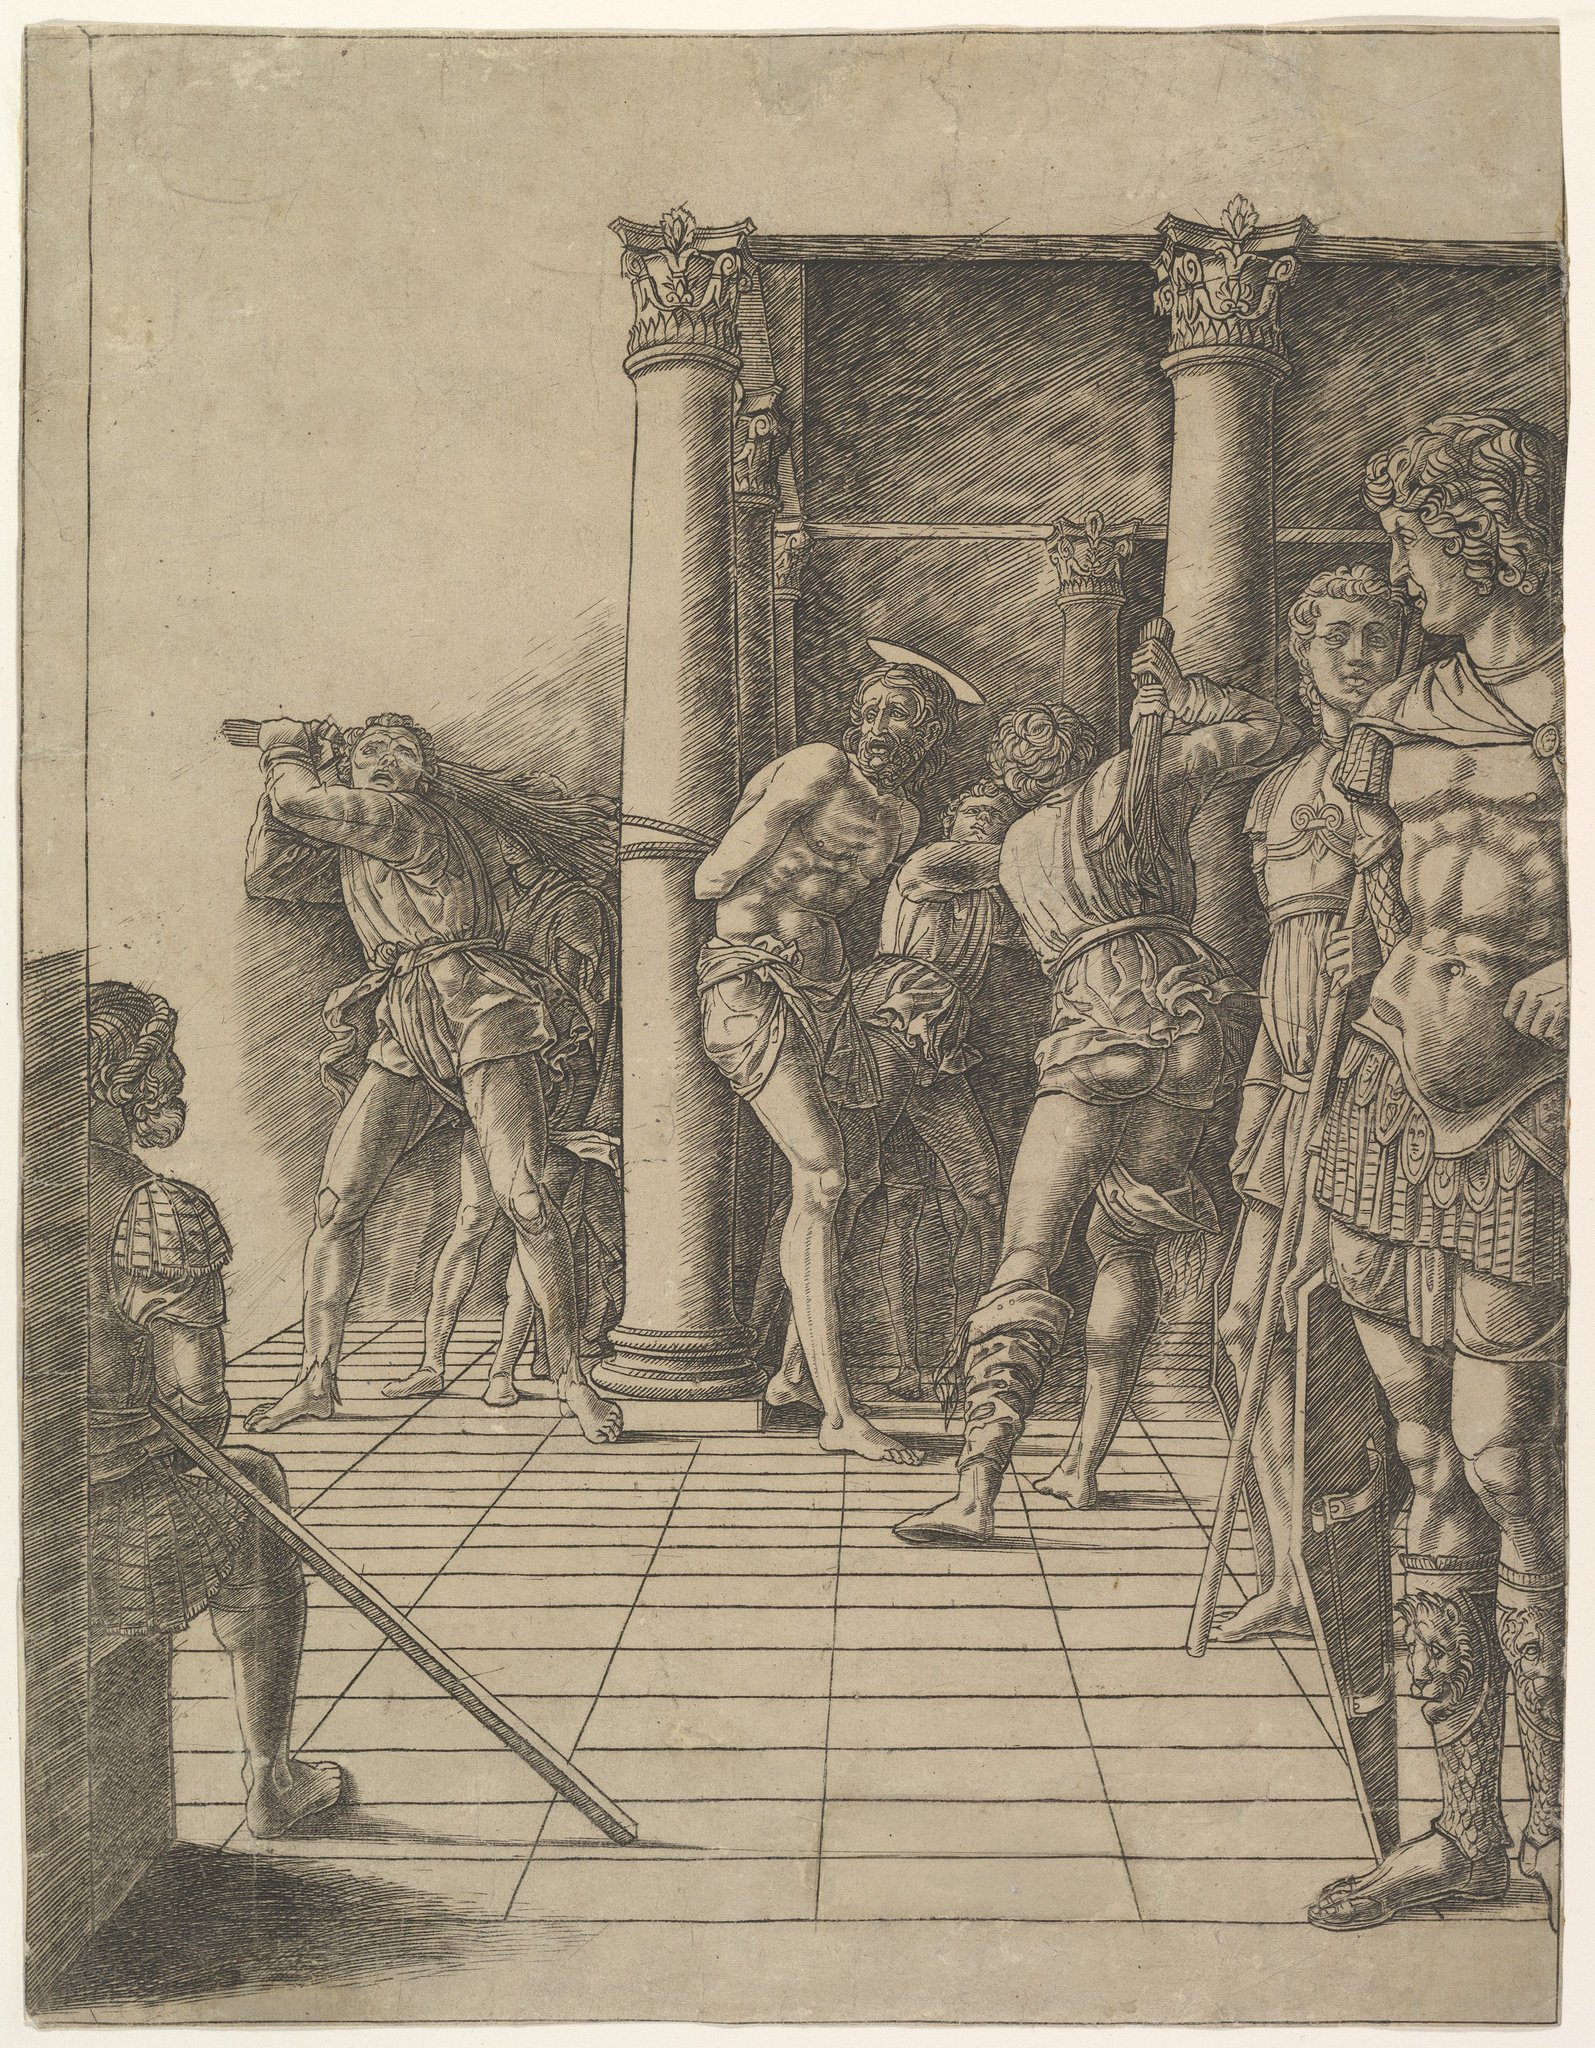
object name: print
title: The Flagellation, with the Pavement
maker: gian marco cavalli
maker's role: artist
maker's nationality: italian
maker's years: 1454-1508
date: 1480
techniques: engraving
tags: men,christ